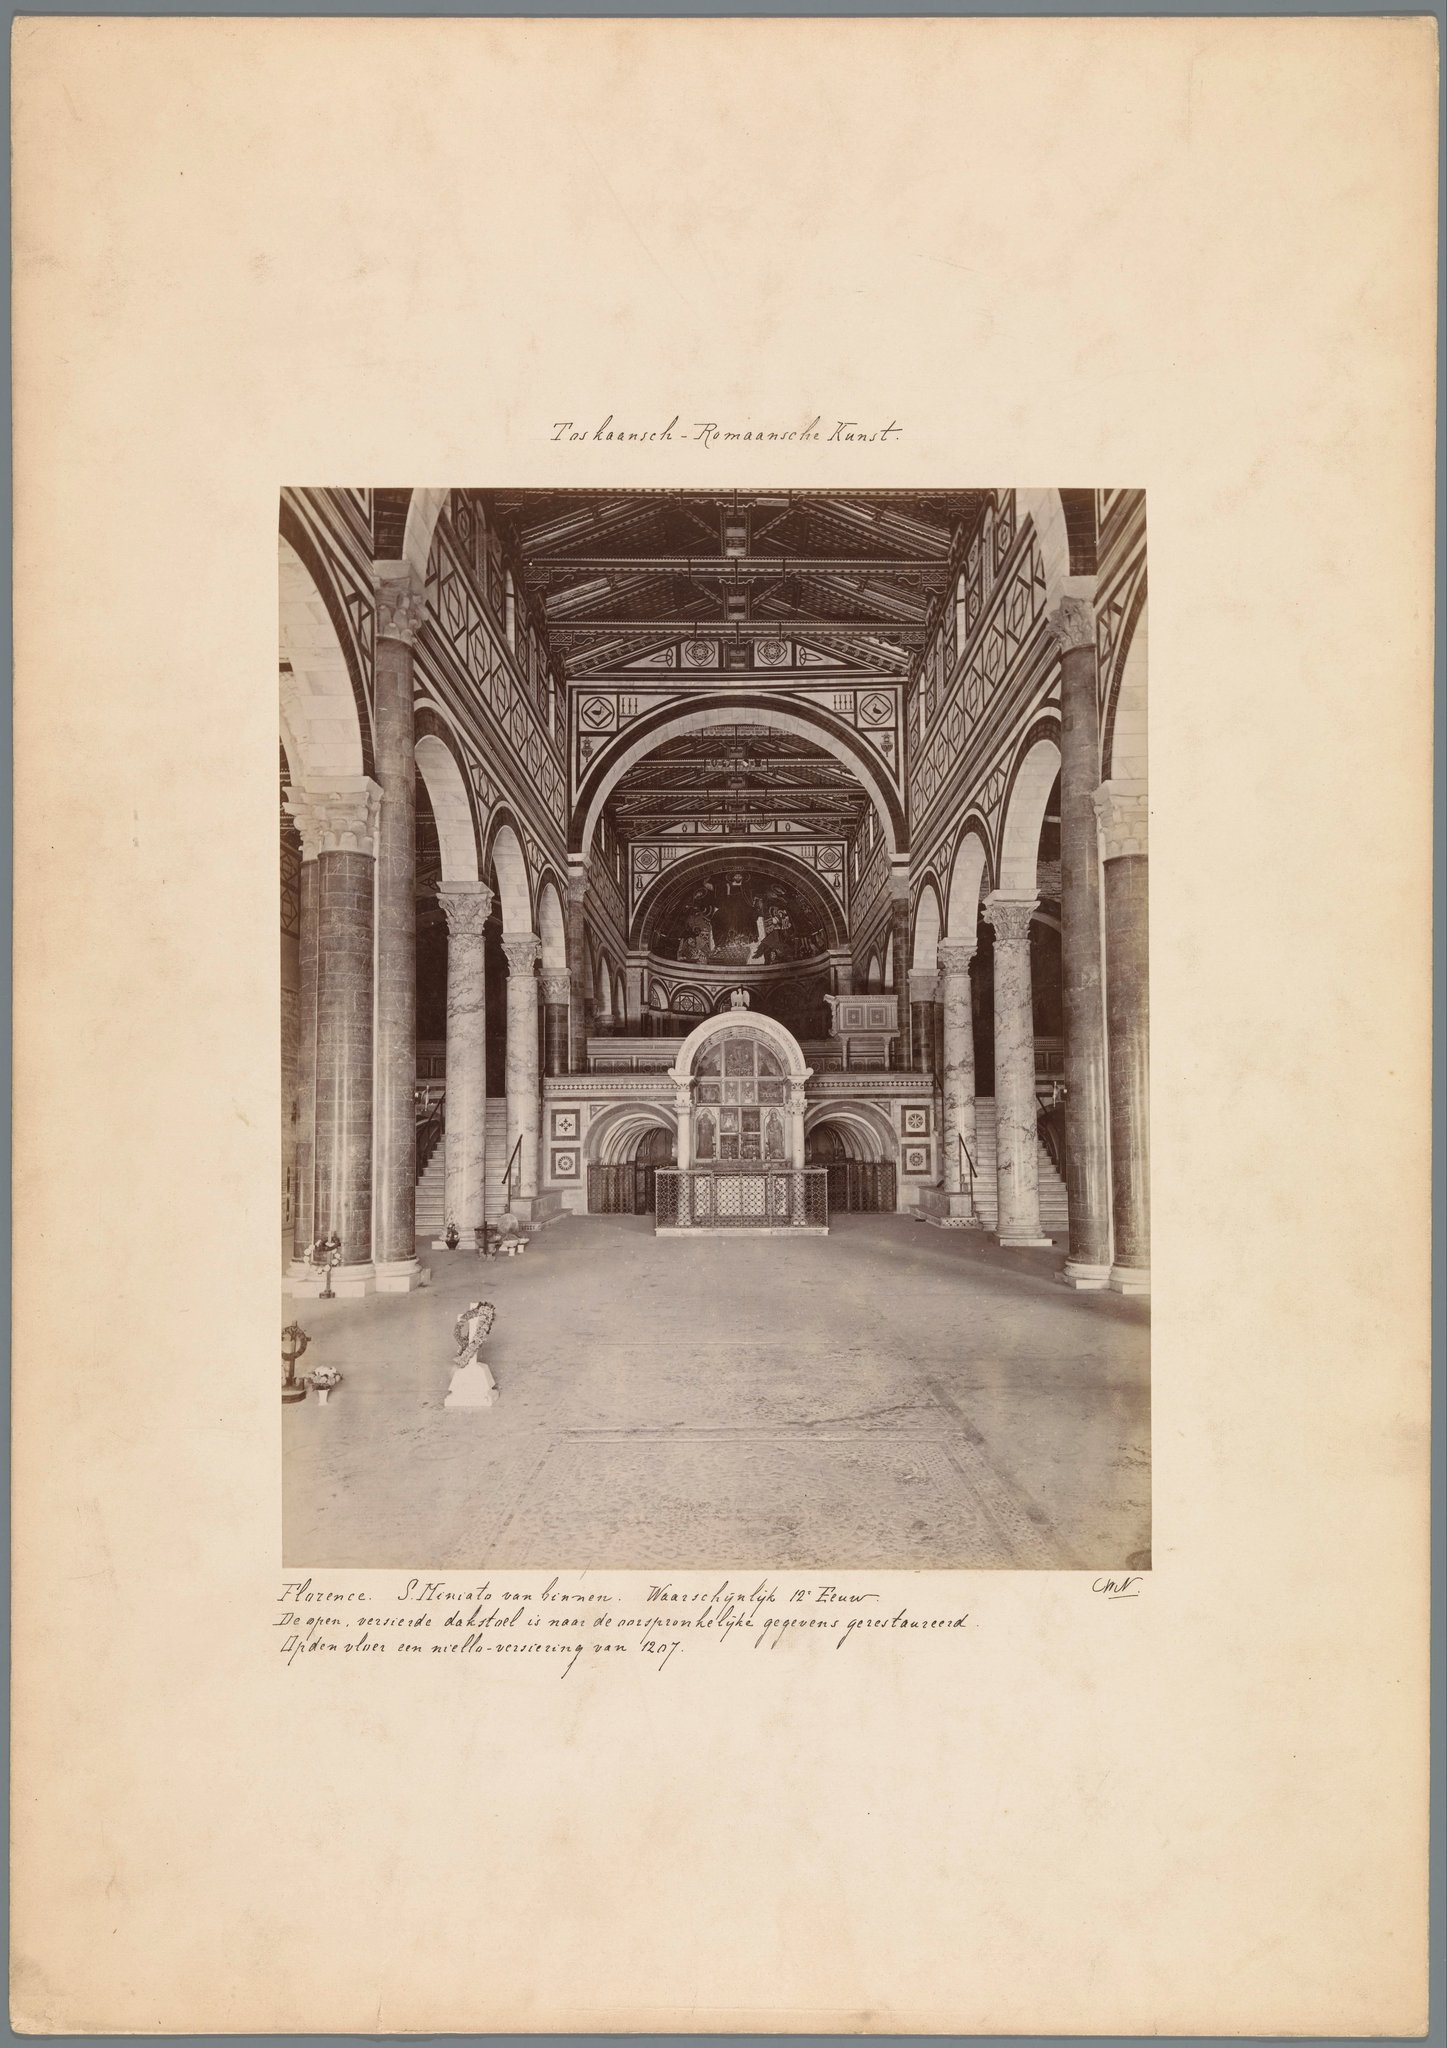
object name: photograph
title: Interieur van de kerk San Miniato al Monte te Florence, met zicht op het koor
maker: Anonymous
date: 1875-1900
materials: cardboard, photographic support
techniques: albumen print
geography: s. miniato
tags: column, pillar ~ architecture, parts of church interior: nave, interior of church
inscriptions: inscription: ‘CWN.’, collector's mark: ‘INSTITUUT VOOR KUNST- NIJVERHEIDSONDERWIJS GABRIËL METSUSTRAAT No. 16. AMSTERDAM’, inscription: ‘Toskaansch-Romaansche Kunst. Florence (...) Op den vloer een niella-versiering van 1207.’, collector's mark: ‘KUNSTNIJVERHEIDSCHOOL QUELLINUS AMSTERDAM FRANS HALSSTRAAT 14.’